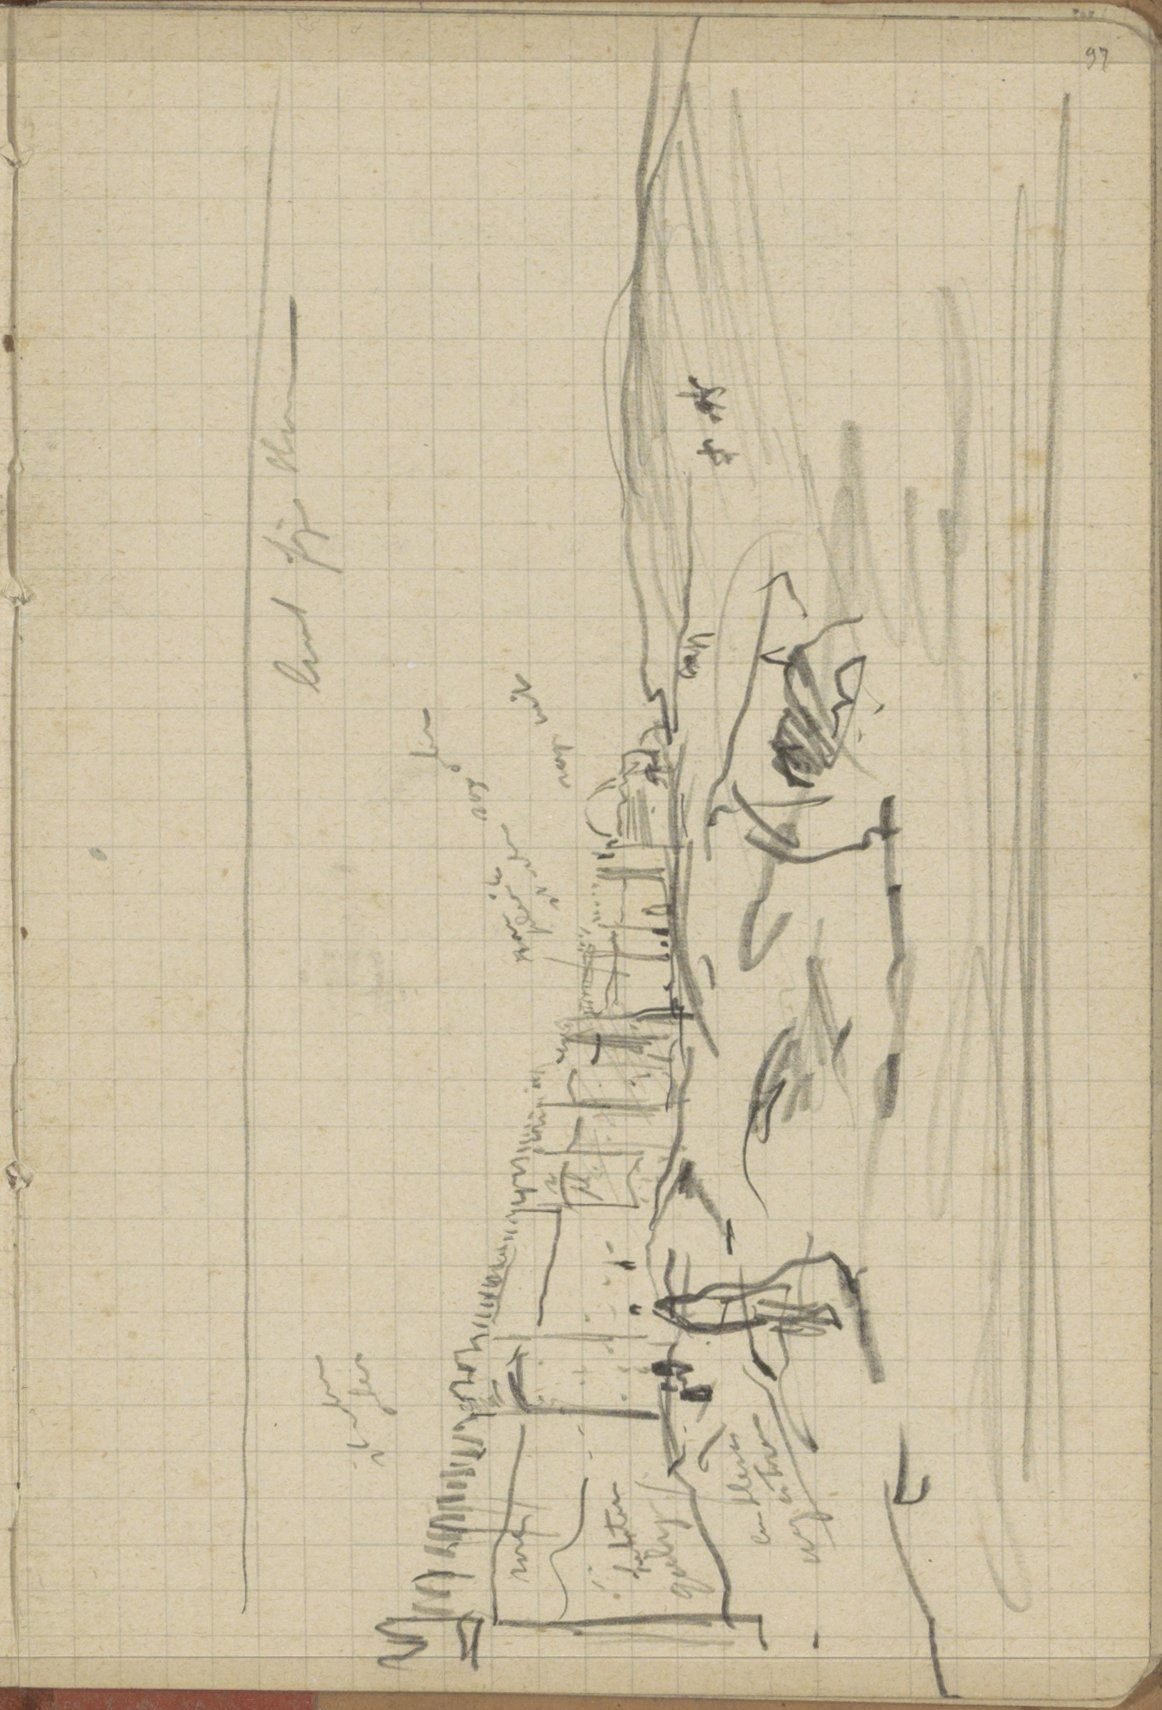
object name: sketchbook leaf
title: Stadsmuur met verdedigingstorens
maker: marius bauer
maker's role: draughtsman, print maker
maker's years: 1867-1932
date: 1909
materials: pencil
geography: tunisia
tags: city-view, and landscape with man-made constructions, towers ~ fortified city, walls ~ fortified city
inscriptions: kleurnotitie, handgeschreven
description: Mogelijk de stadsmuur van Kairouan. Pagina 97 uit een schetsboek met 67 bladen.